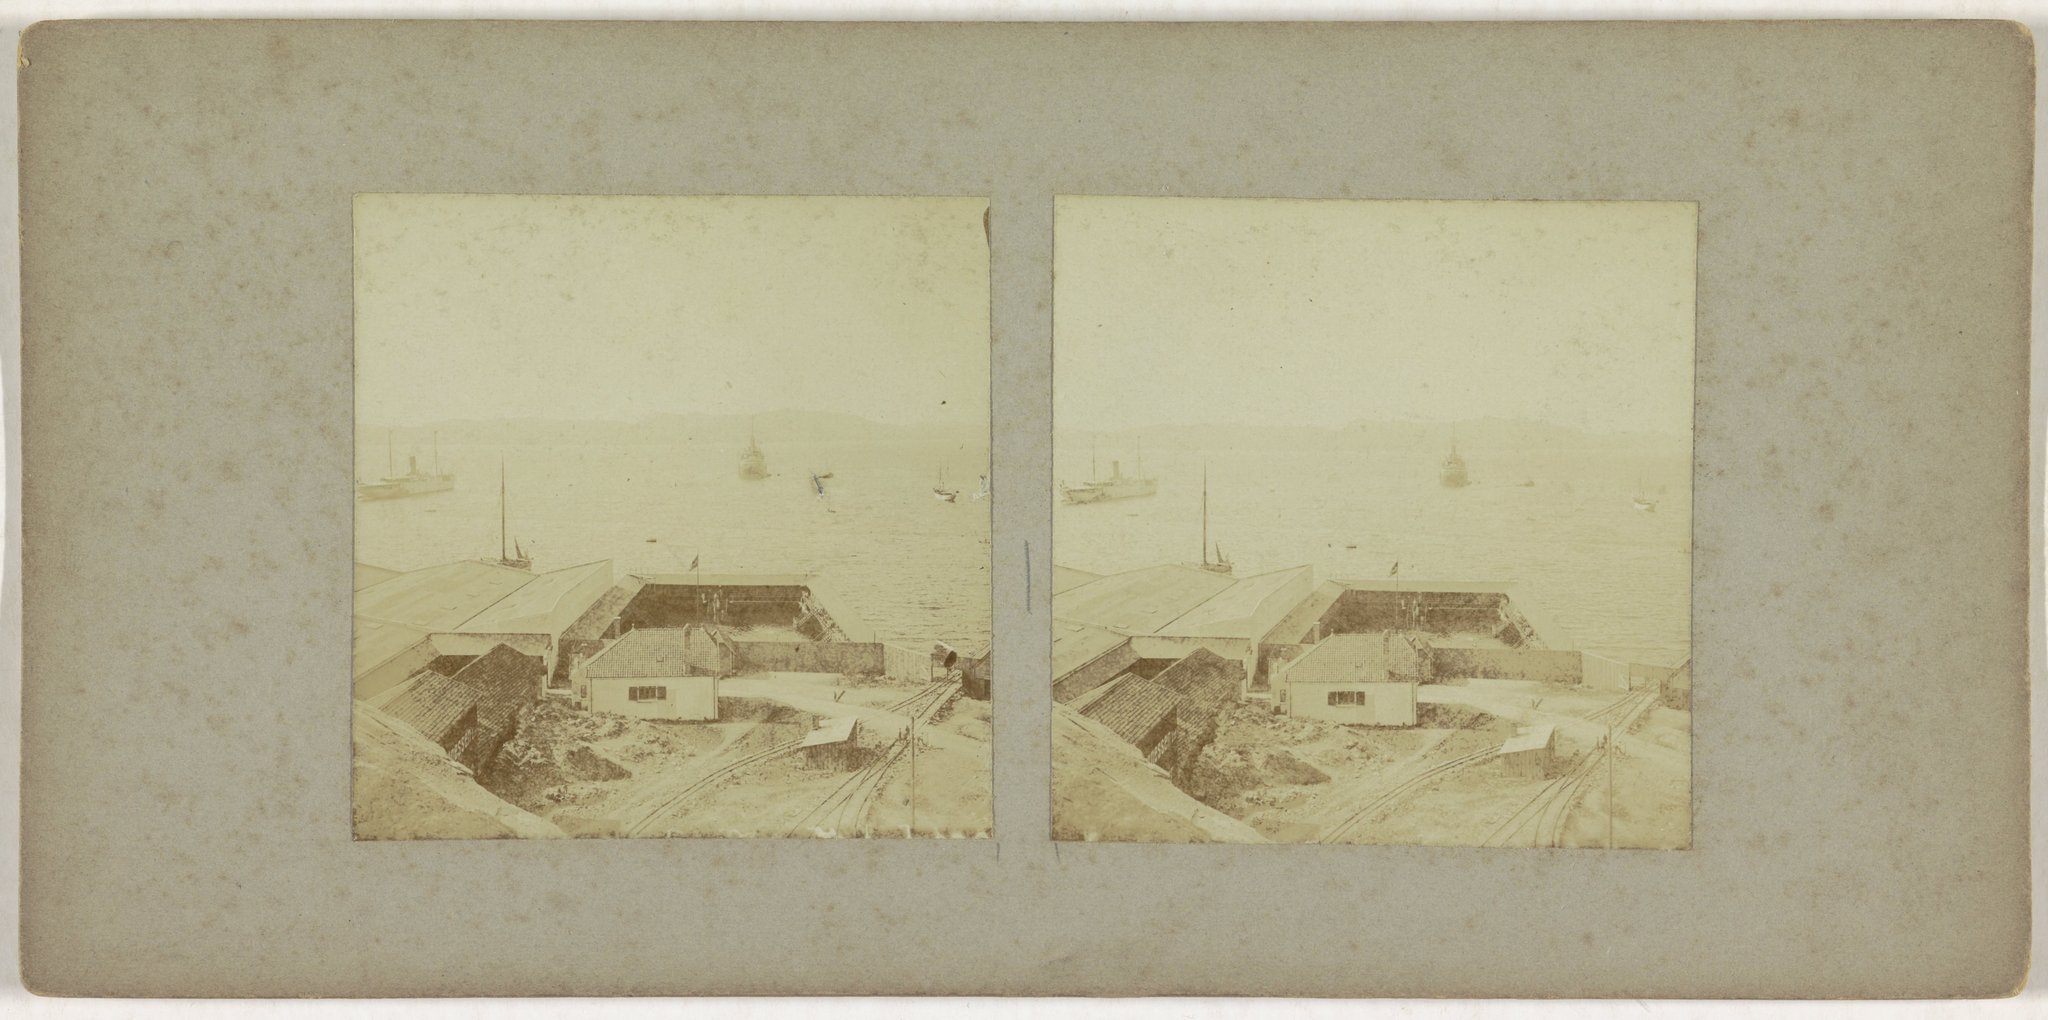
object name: stereograph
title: Gezicht op de haven van Bergen, Noorwegen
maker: Anonymous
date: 1882-1890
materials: paper, cardboard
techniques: gelatin silver print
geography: bergen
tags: harbour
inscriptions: inscription: ‘Bergen’